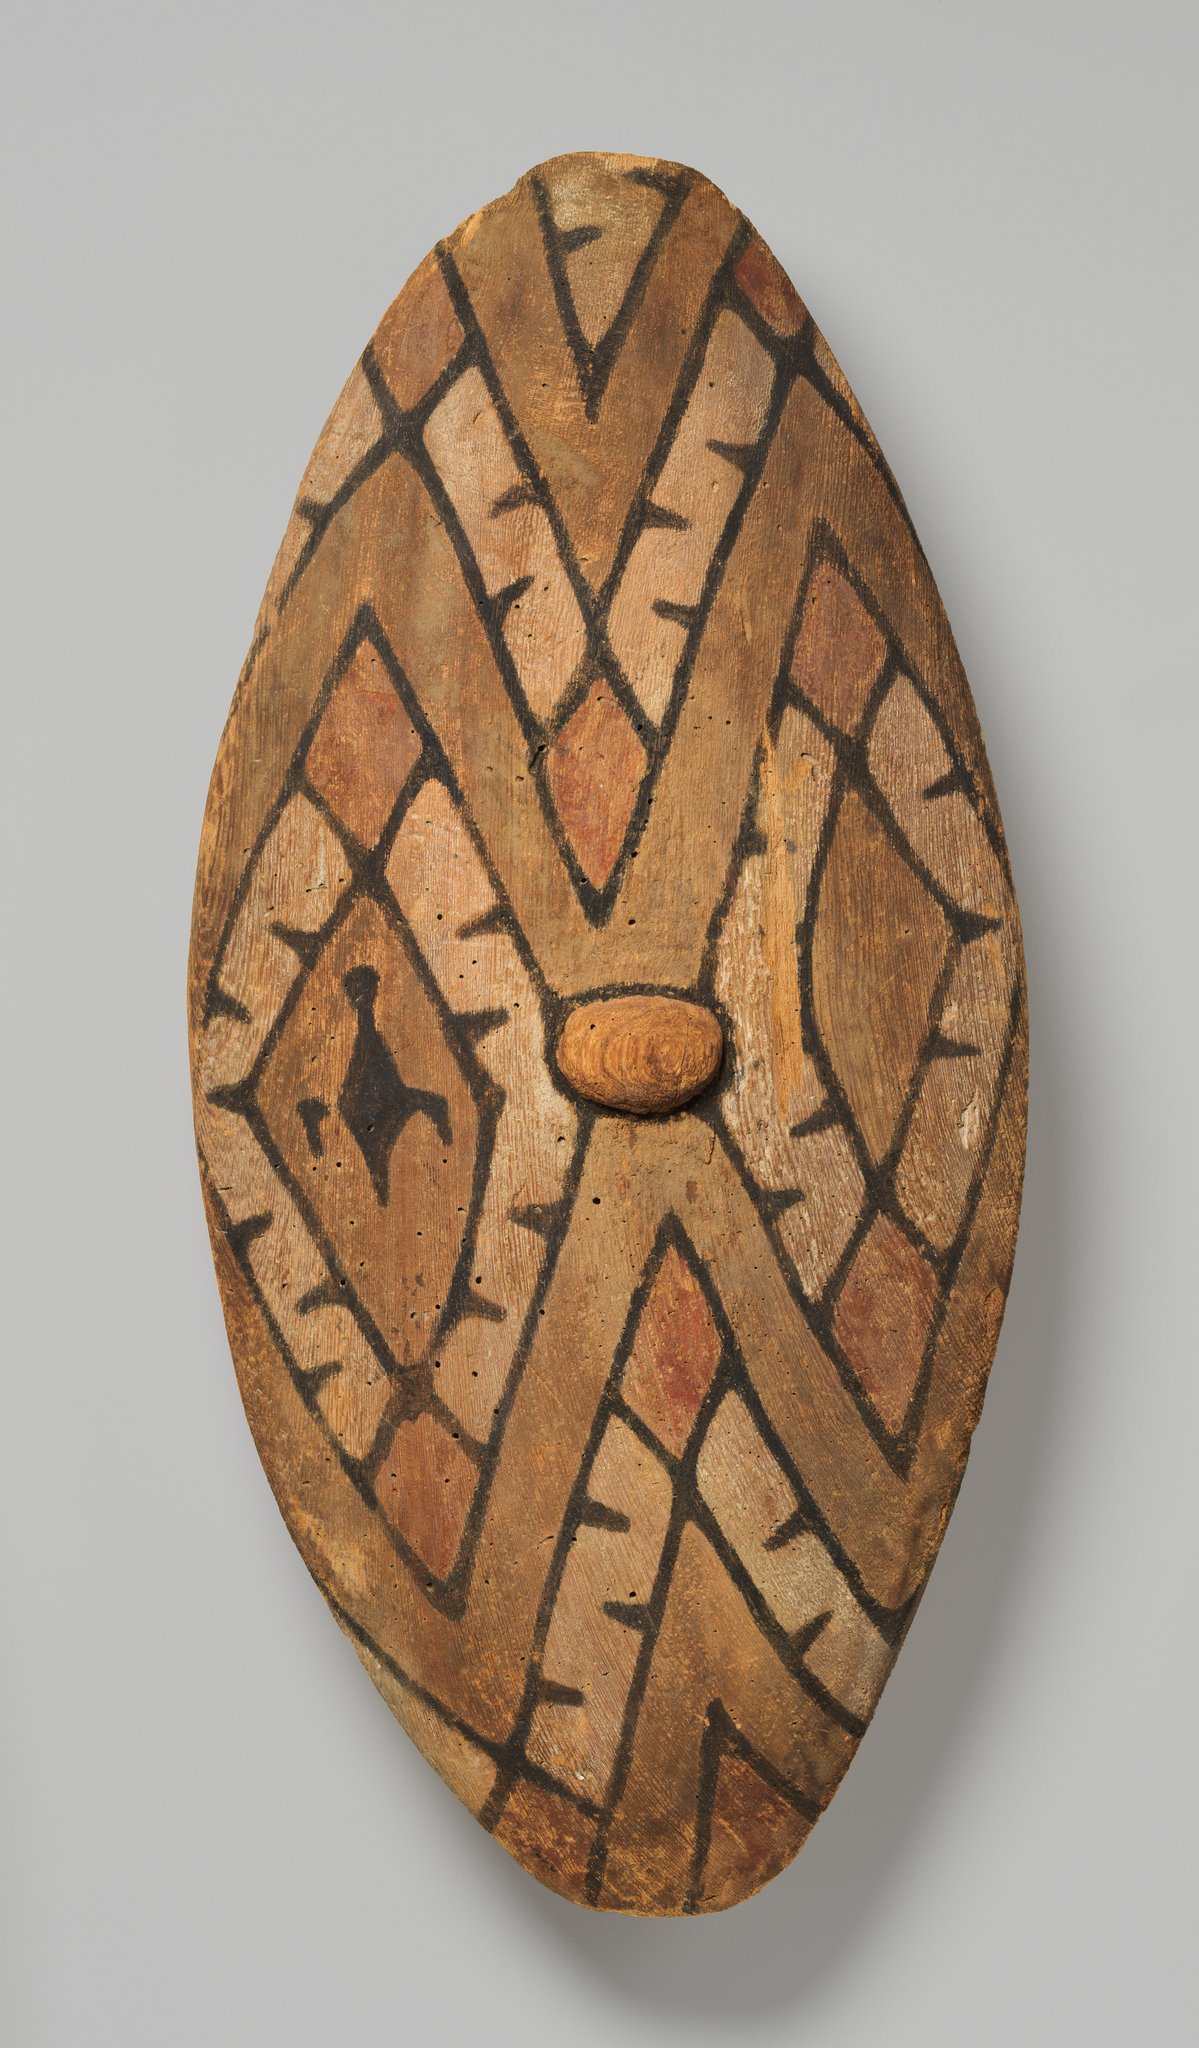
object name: shield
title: Rainforest shield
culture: northeastern queensland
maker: aboriginal artist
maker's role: artist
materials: pigment, wood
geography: australia